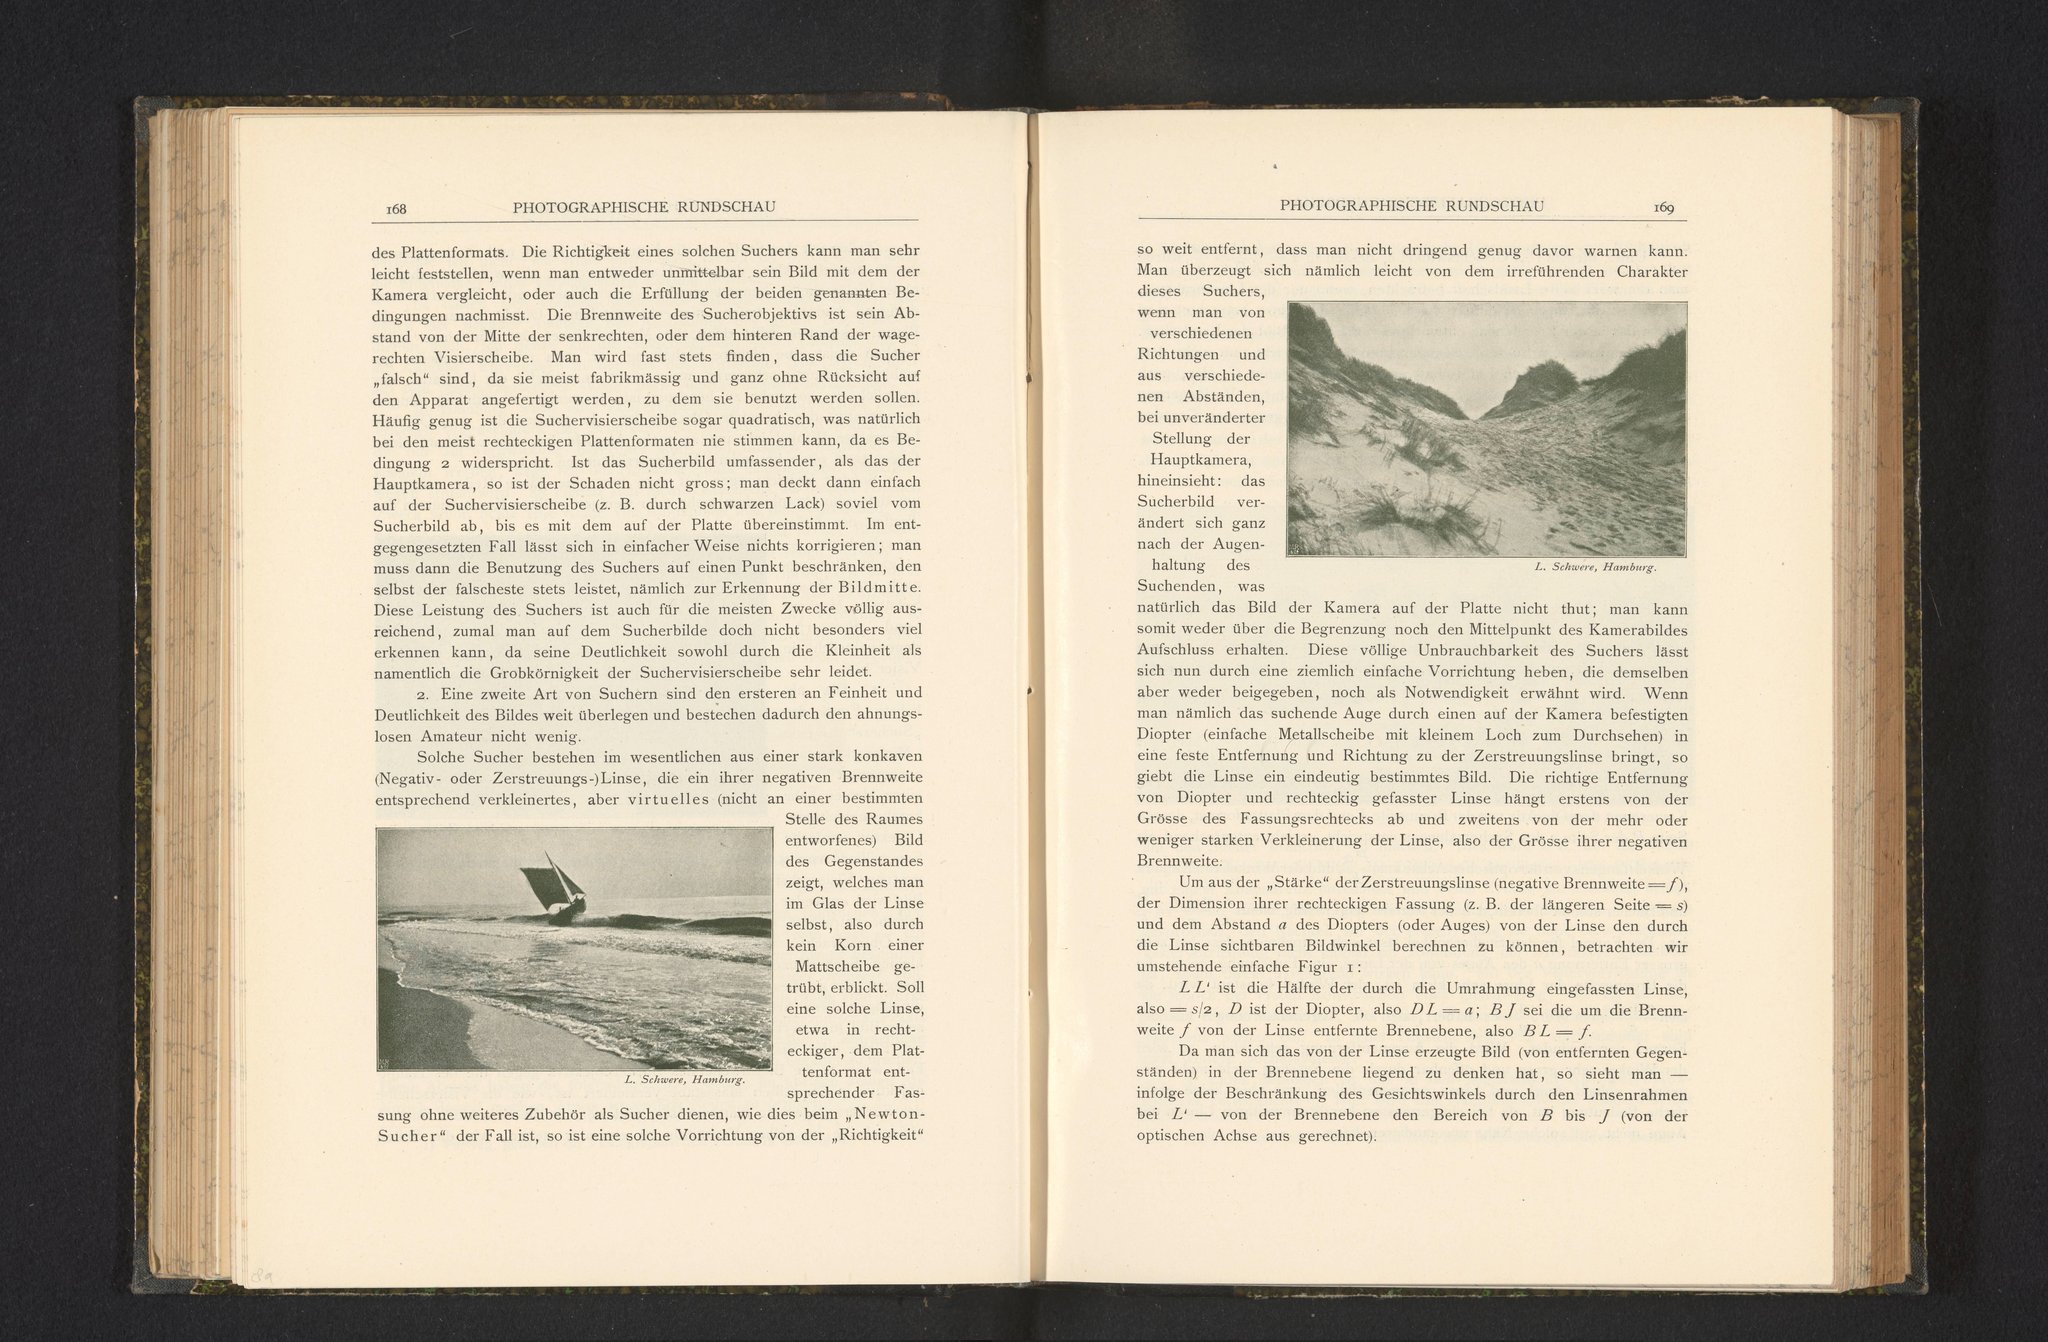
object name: photomechanical print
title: Zeilschip in de branding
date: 1893-1898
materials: paper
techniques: autotype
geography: hamburg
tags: sailing-ship, sailing-boat, beach